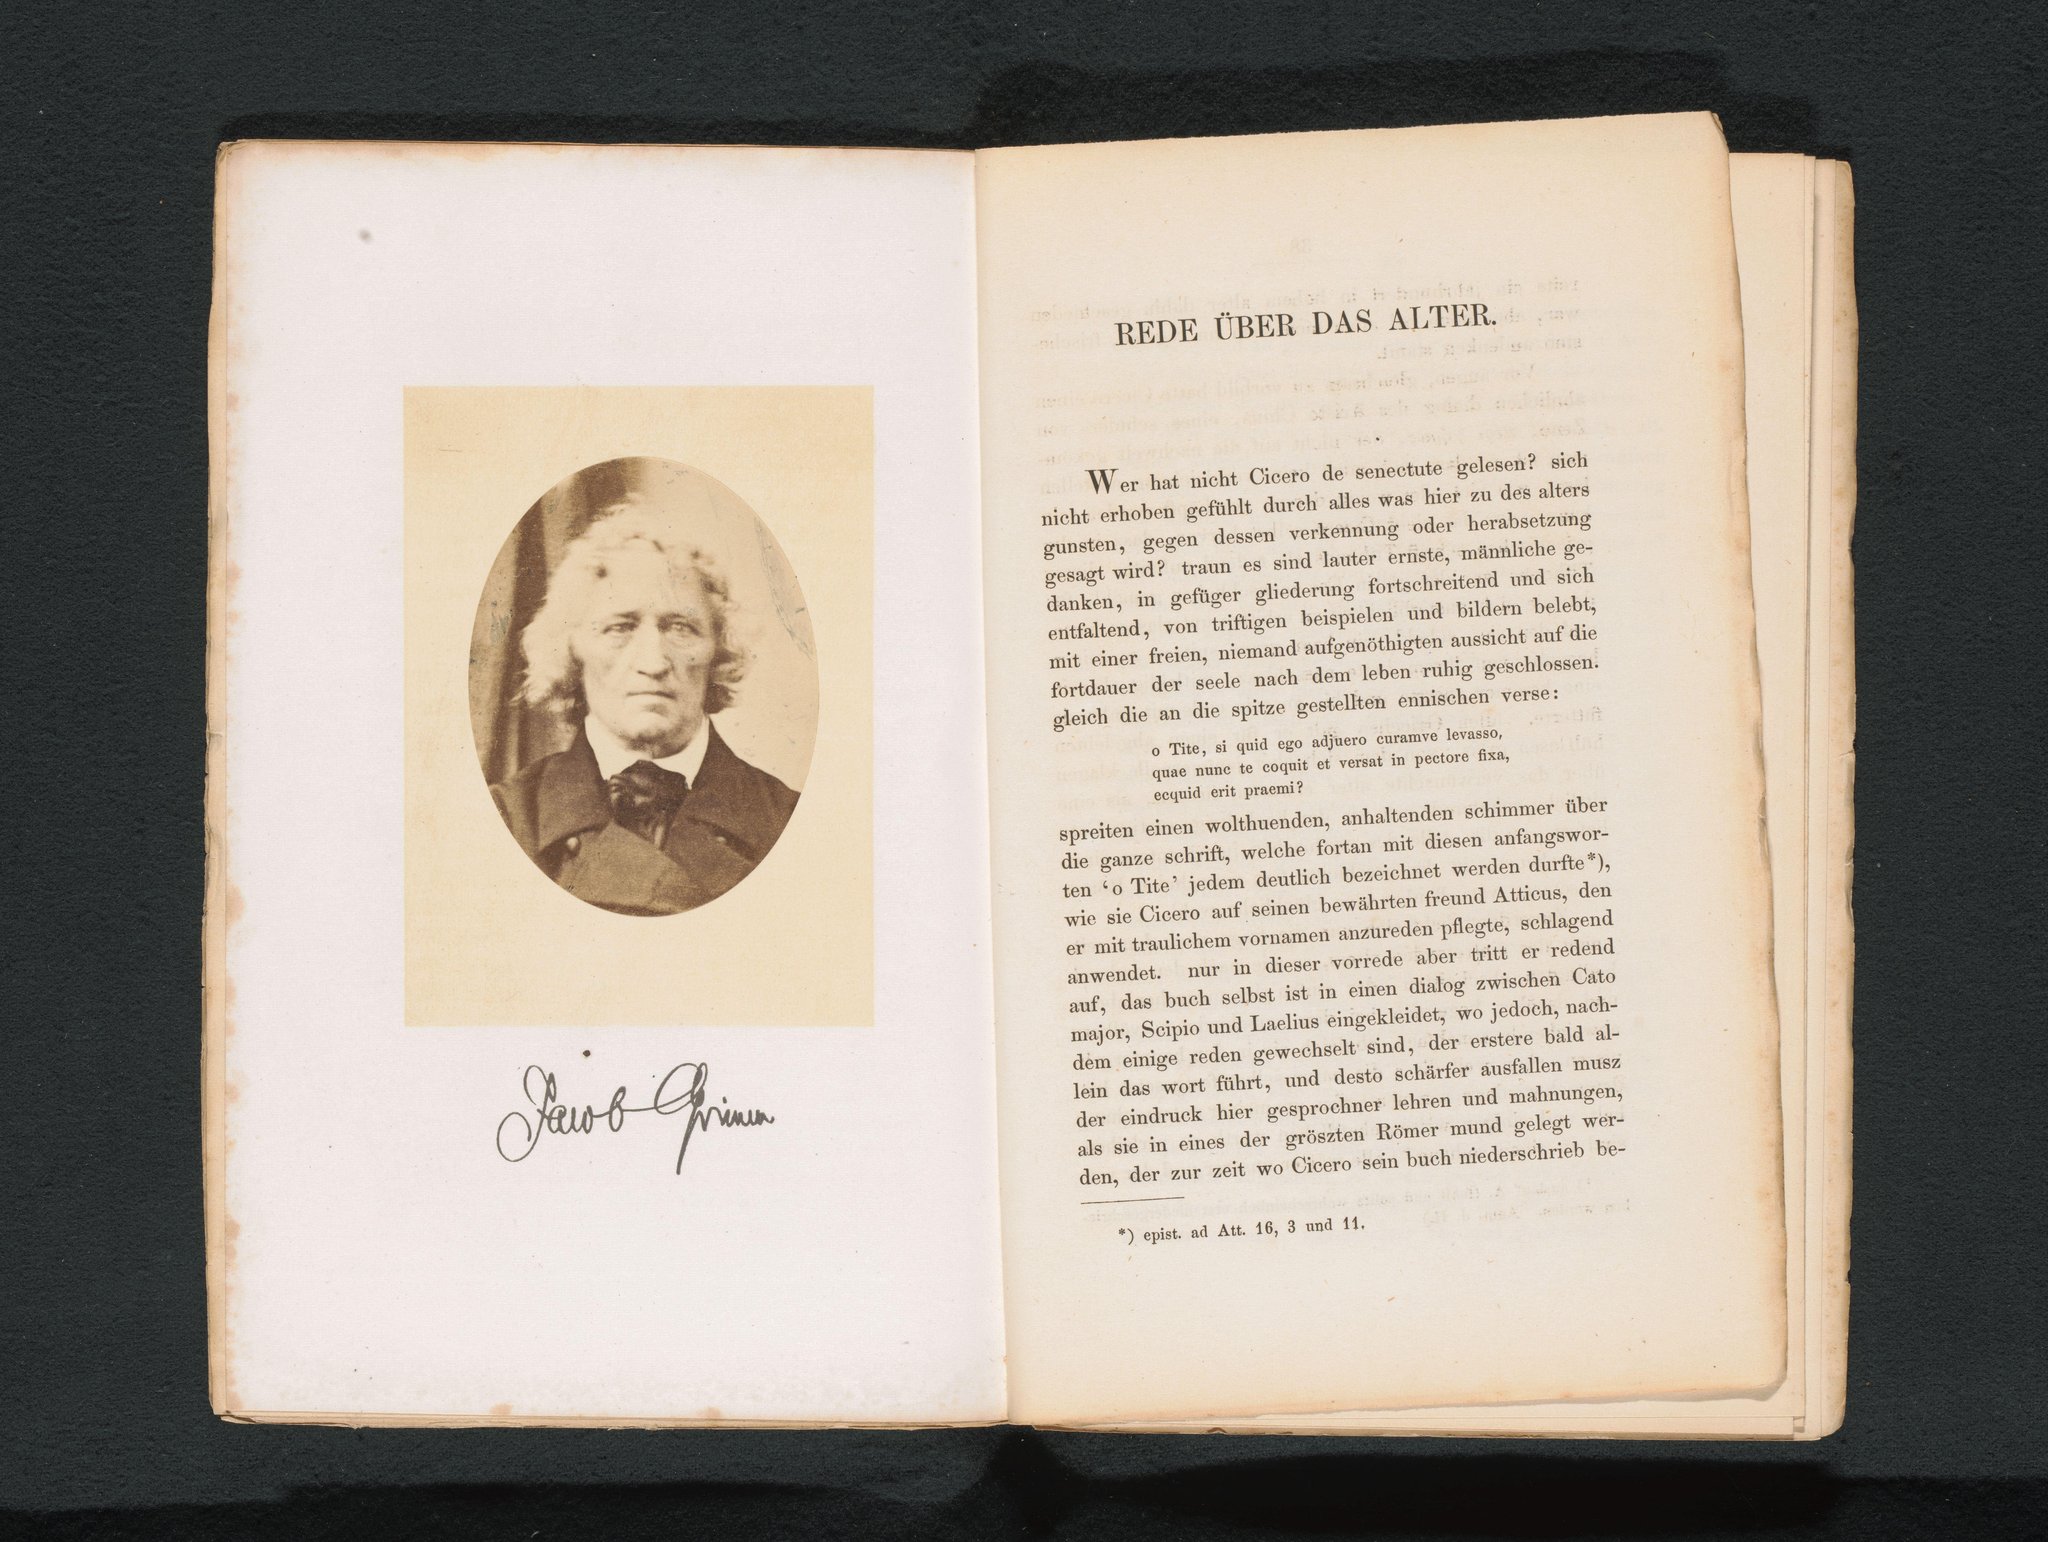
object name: photograph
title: Portret van Jacob Grimm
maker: Anonymous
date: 1859-1864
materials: paper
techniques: albumen print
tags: berlin, jacob ludwig karl grimm, historical persons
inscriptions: inscription: ‘Jacob Grimm’